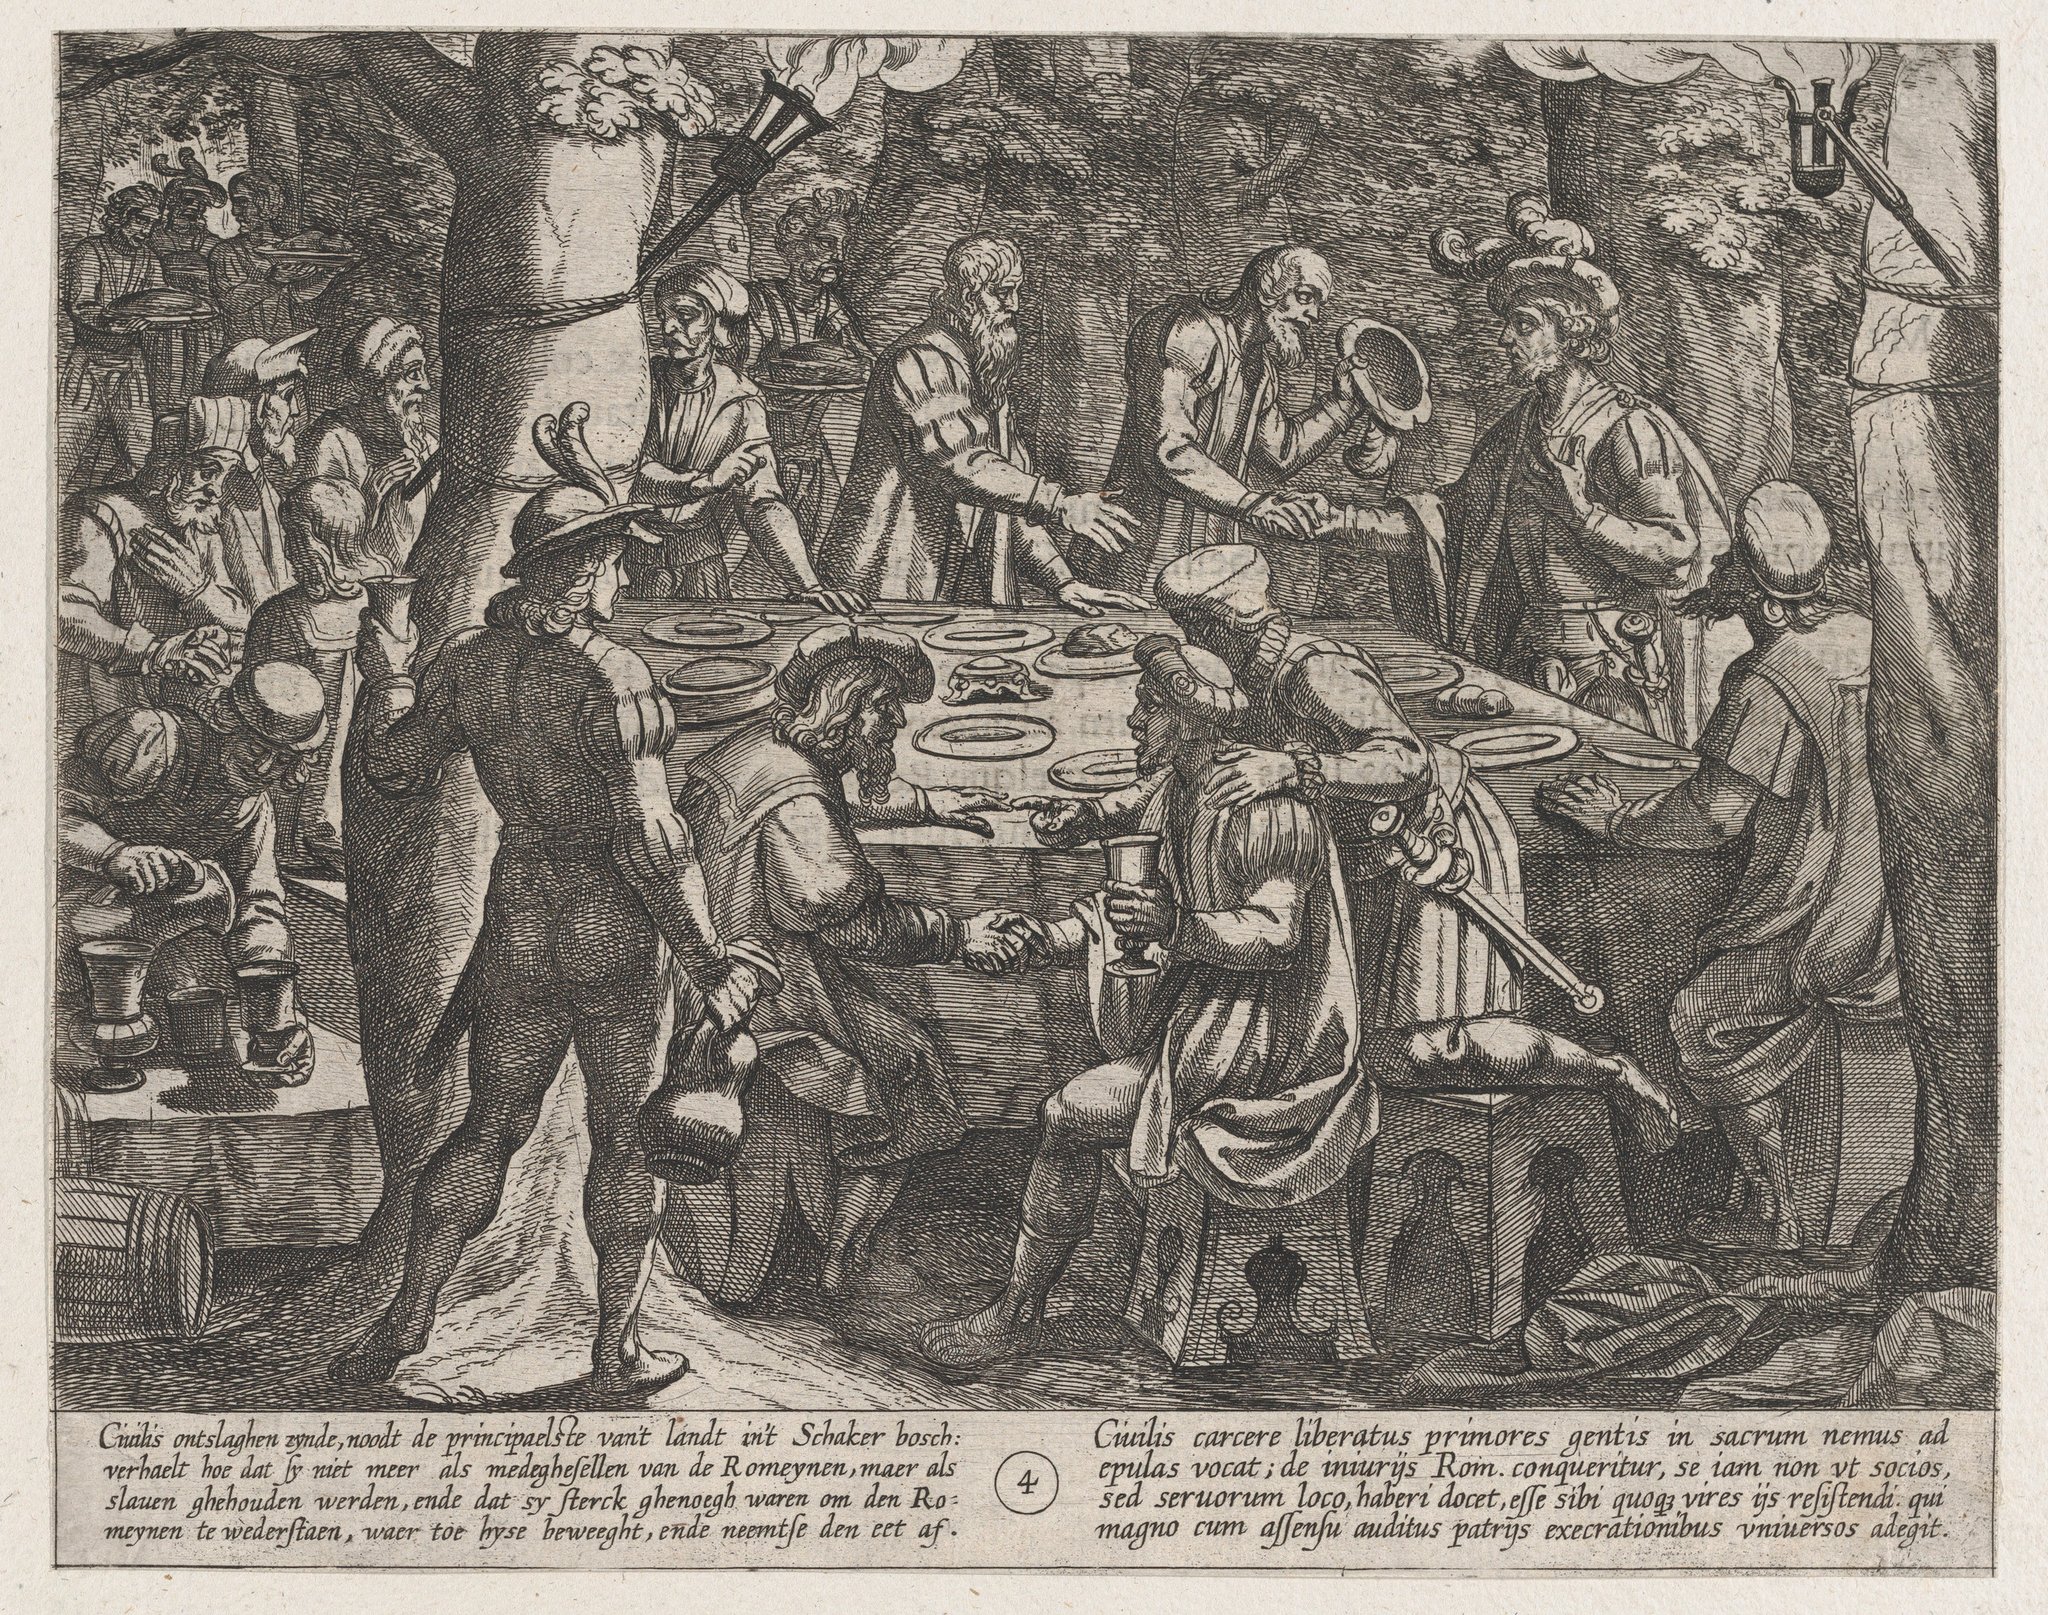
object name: print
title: Plate 4: Civilis tells the Dutch Elders that They are Being Treated Like Slaves by the Romans, from The War of the Romans Against the Batavians (Romanorvm et Batavorvm societas)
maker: antonio tempesta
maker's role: artist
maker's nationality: italian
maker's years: 1555-1630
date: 1611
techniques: etching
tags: men,women,party